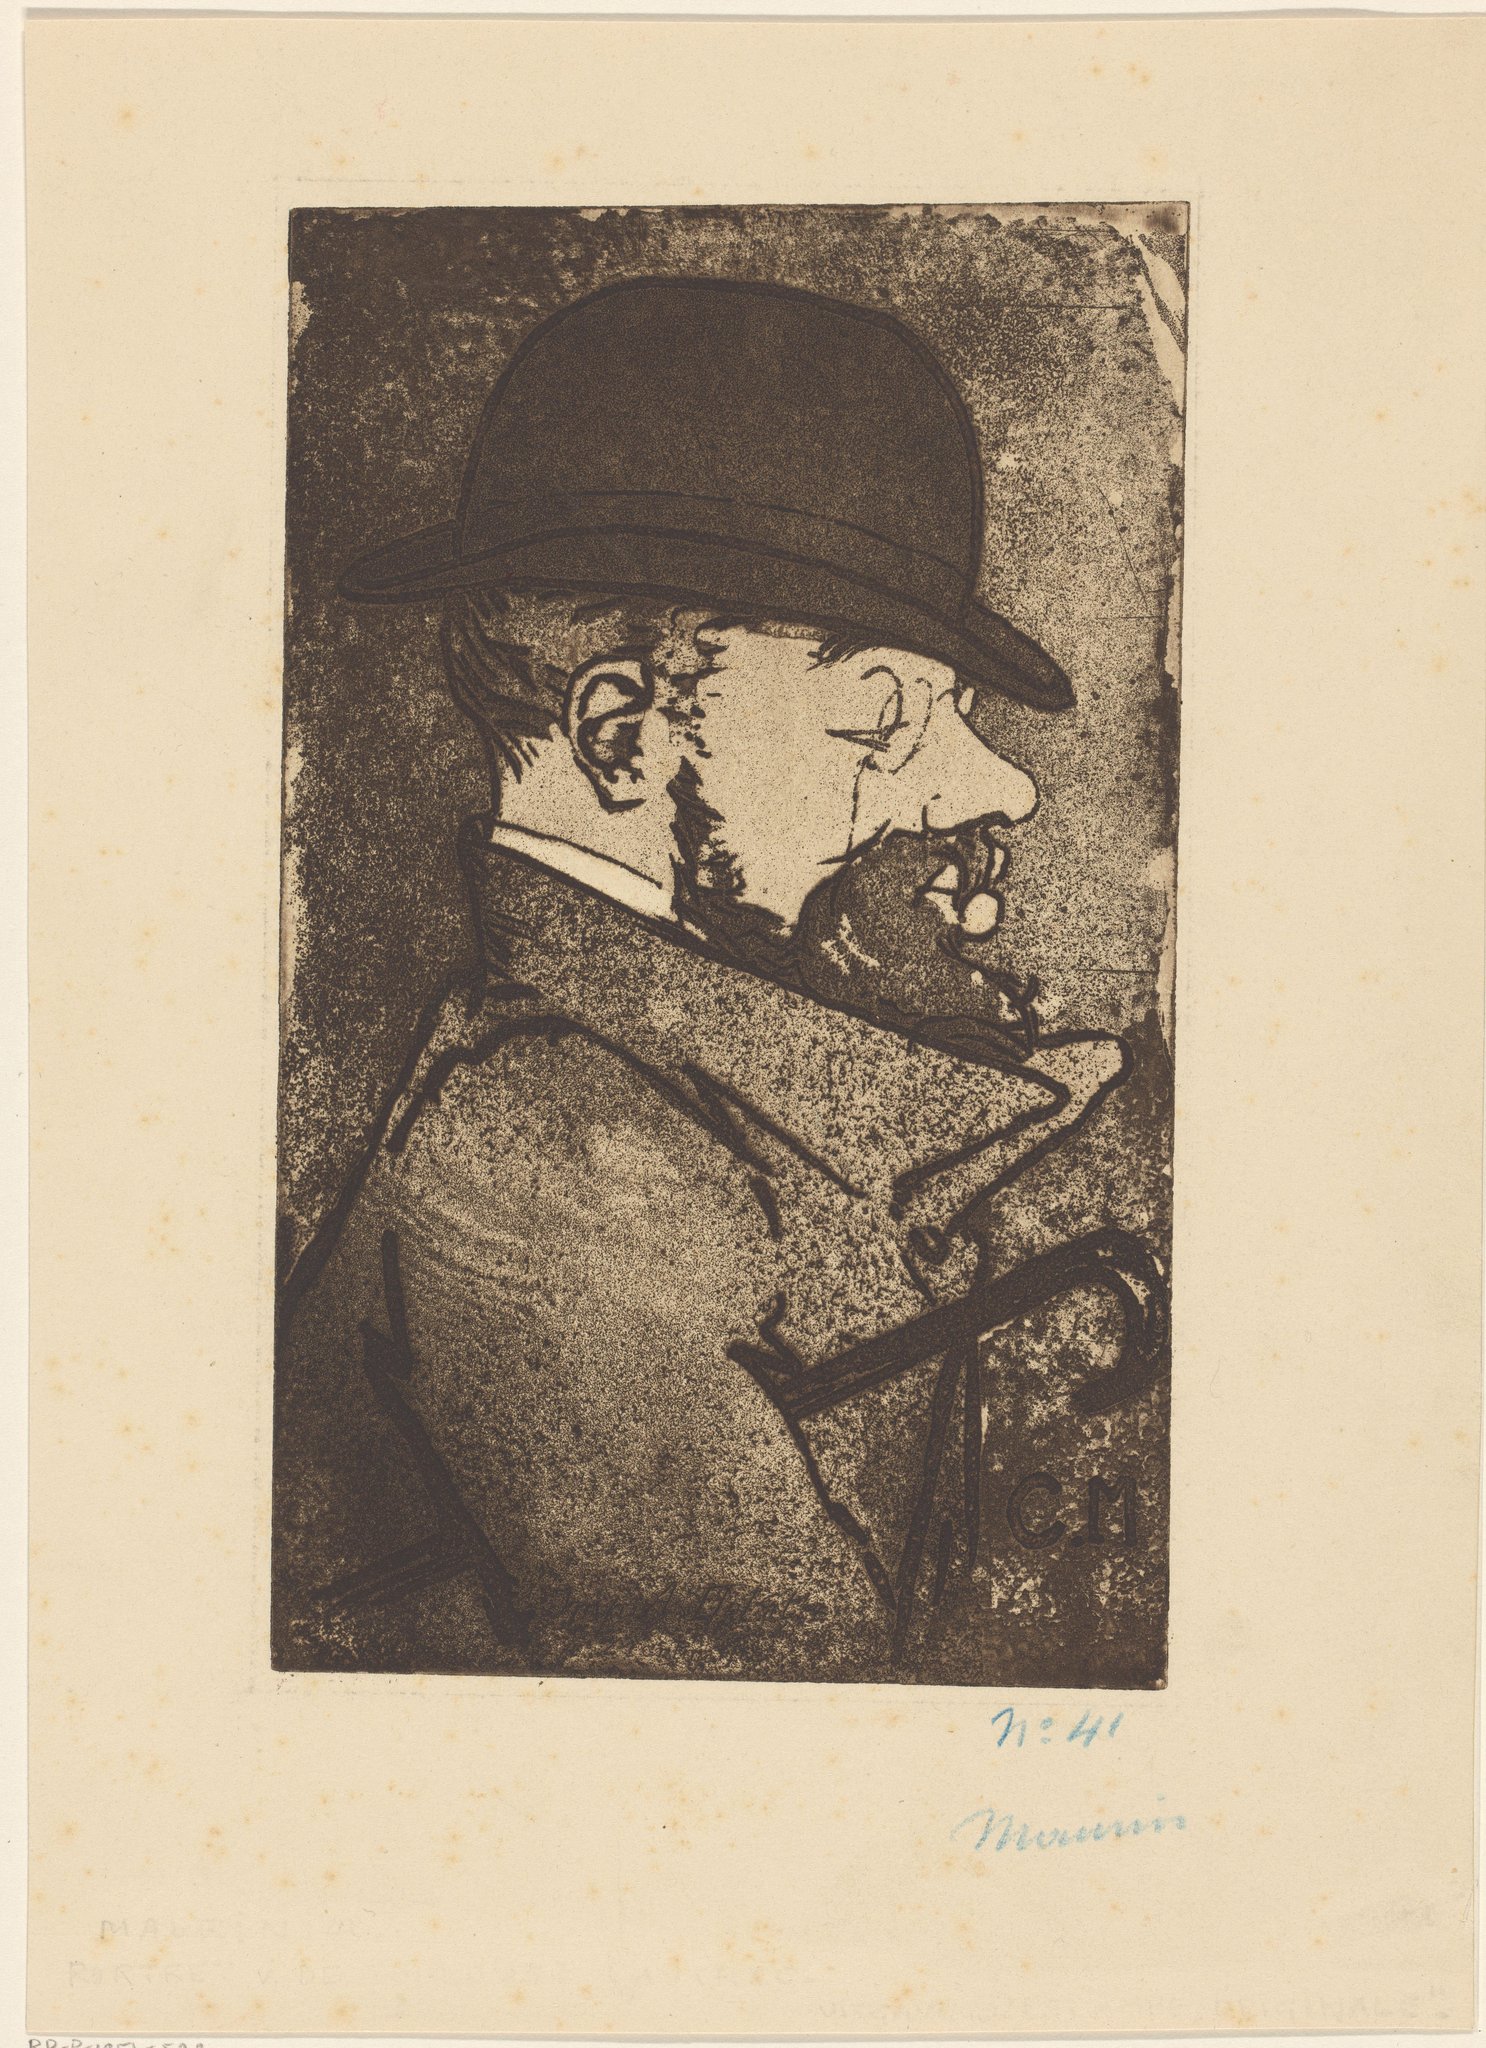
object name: print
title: Portret van Henri de Toulouse-Lautrec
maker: charles maurin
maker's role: print maker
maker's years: 1856-1914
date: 1884-1914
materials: paper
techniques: aquatint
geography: france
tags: painter, print maker, draughtsman, henri de toulouse-lautrec, historical persons, portrait, self-portrait of artist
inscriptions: collector's mark: Lugt 2228